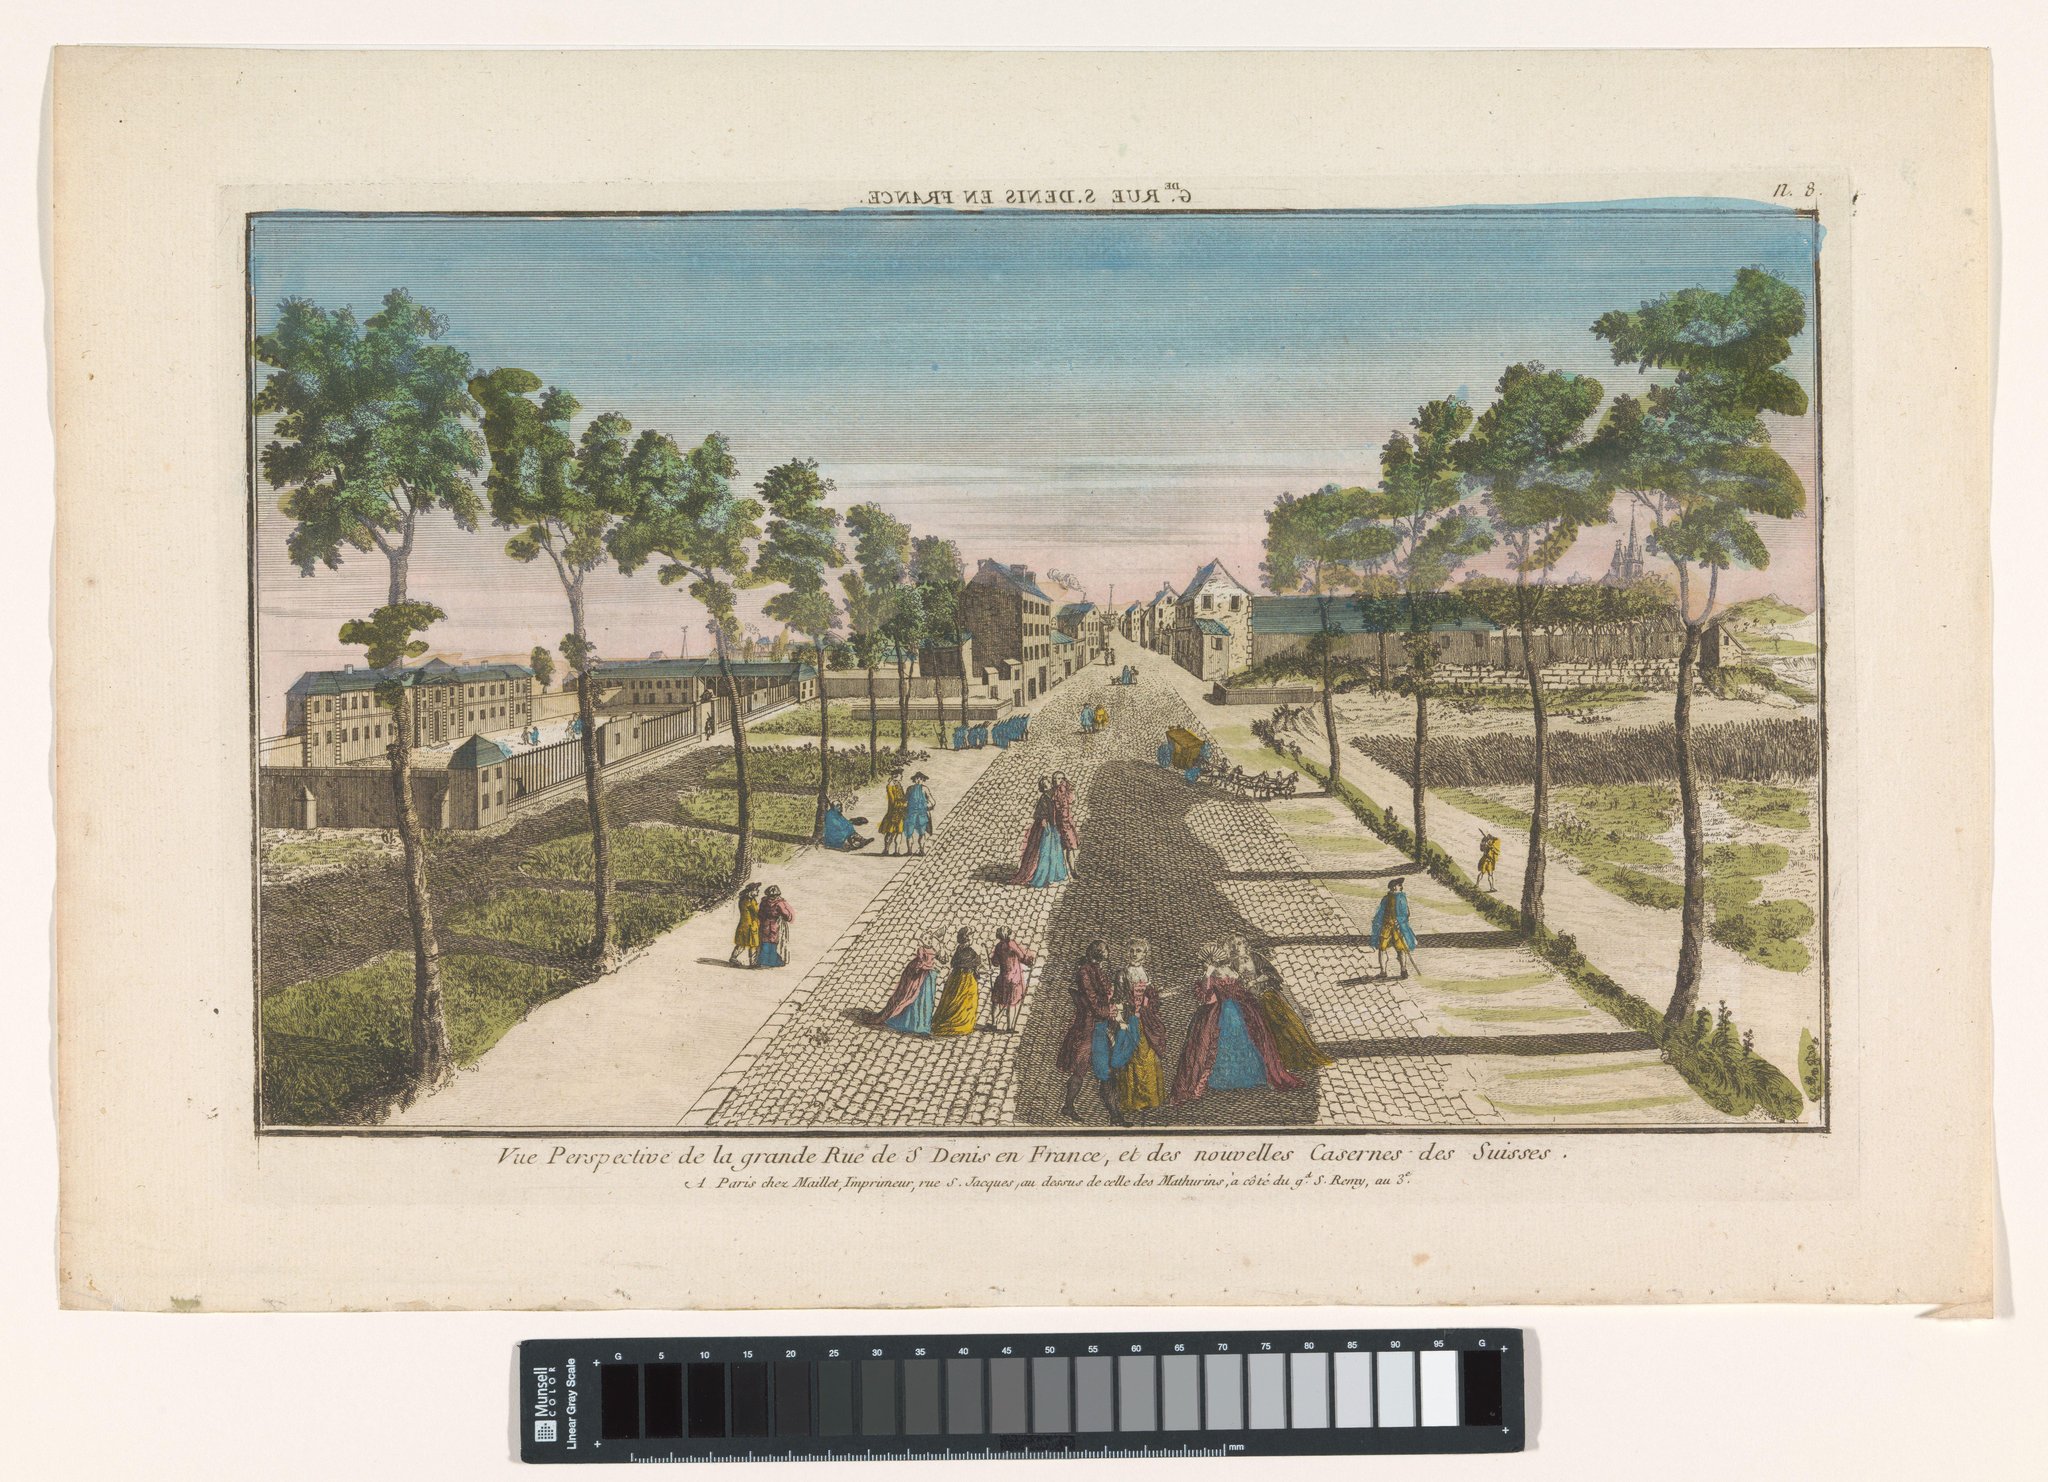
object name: opticaprent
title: Gezicht op de Rue Saint-Denis te Parijs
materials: paper, watercolor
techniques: brush, etching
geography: paris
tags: barracks, street (+ city(-scape) with figures, staffage), paris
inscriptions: watermark, collector's mark: Lugt 2166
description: Links de kazerne van de Zwitserse Garde. Genummerd: 8.